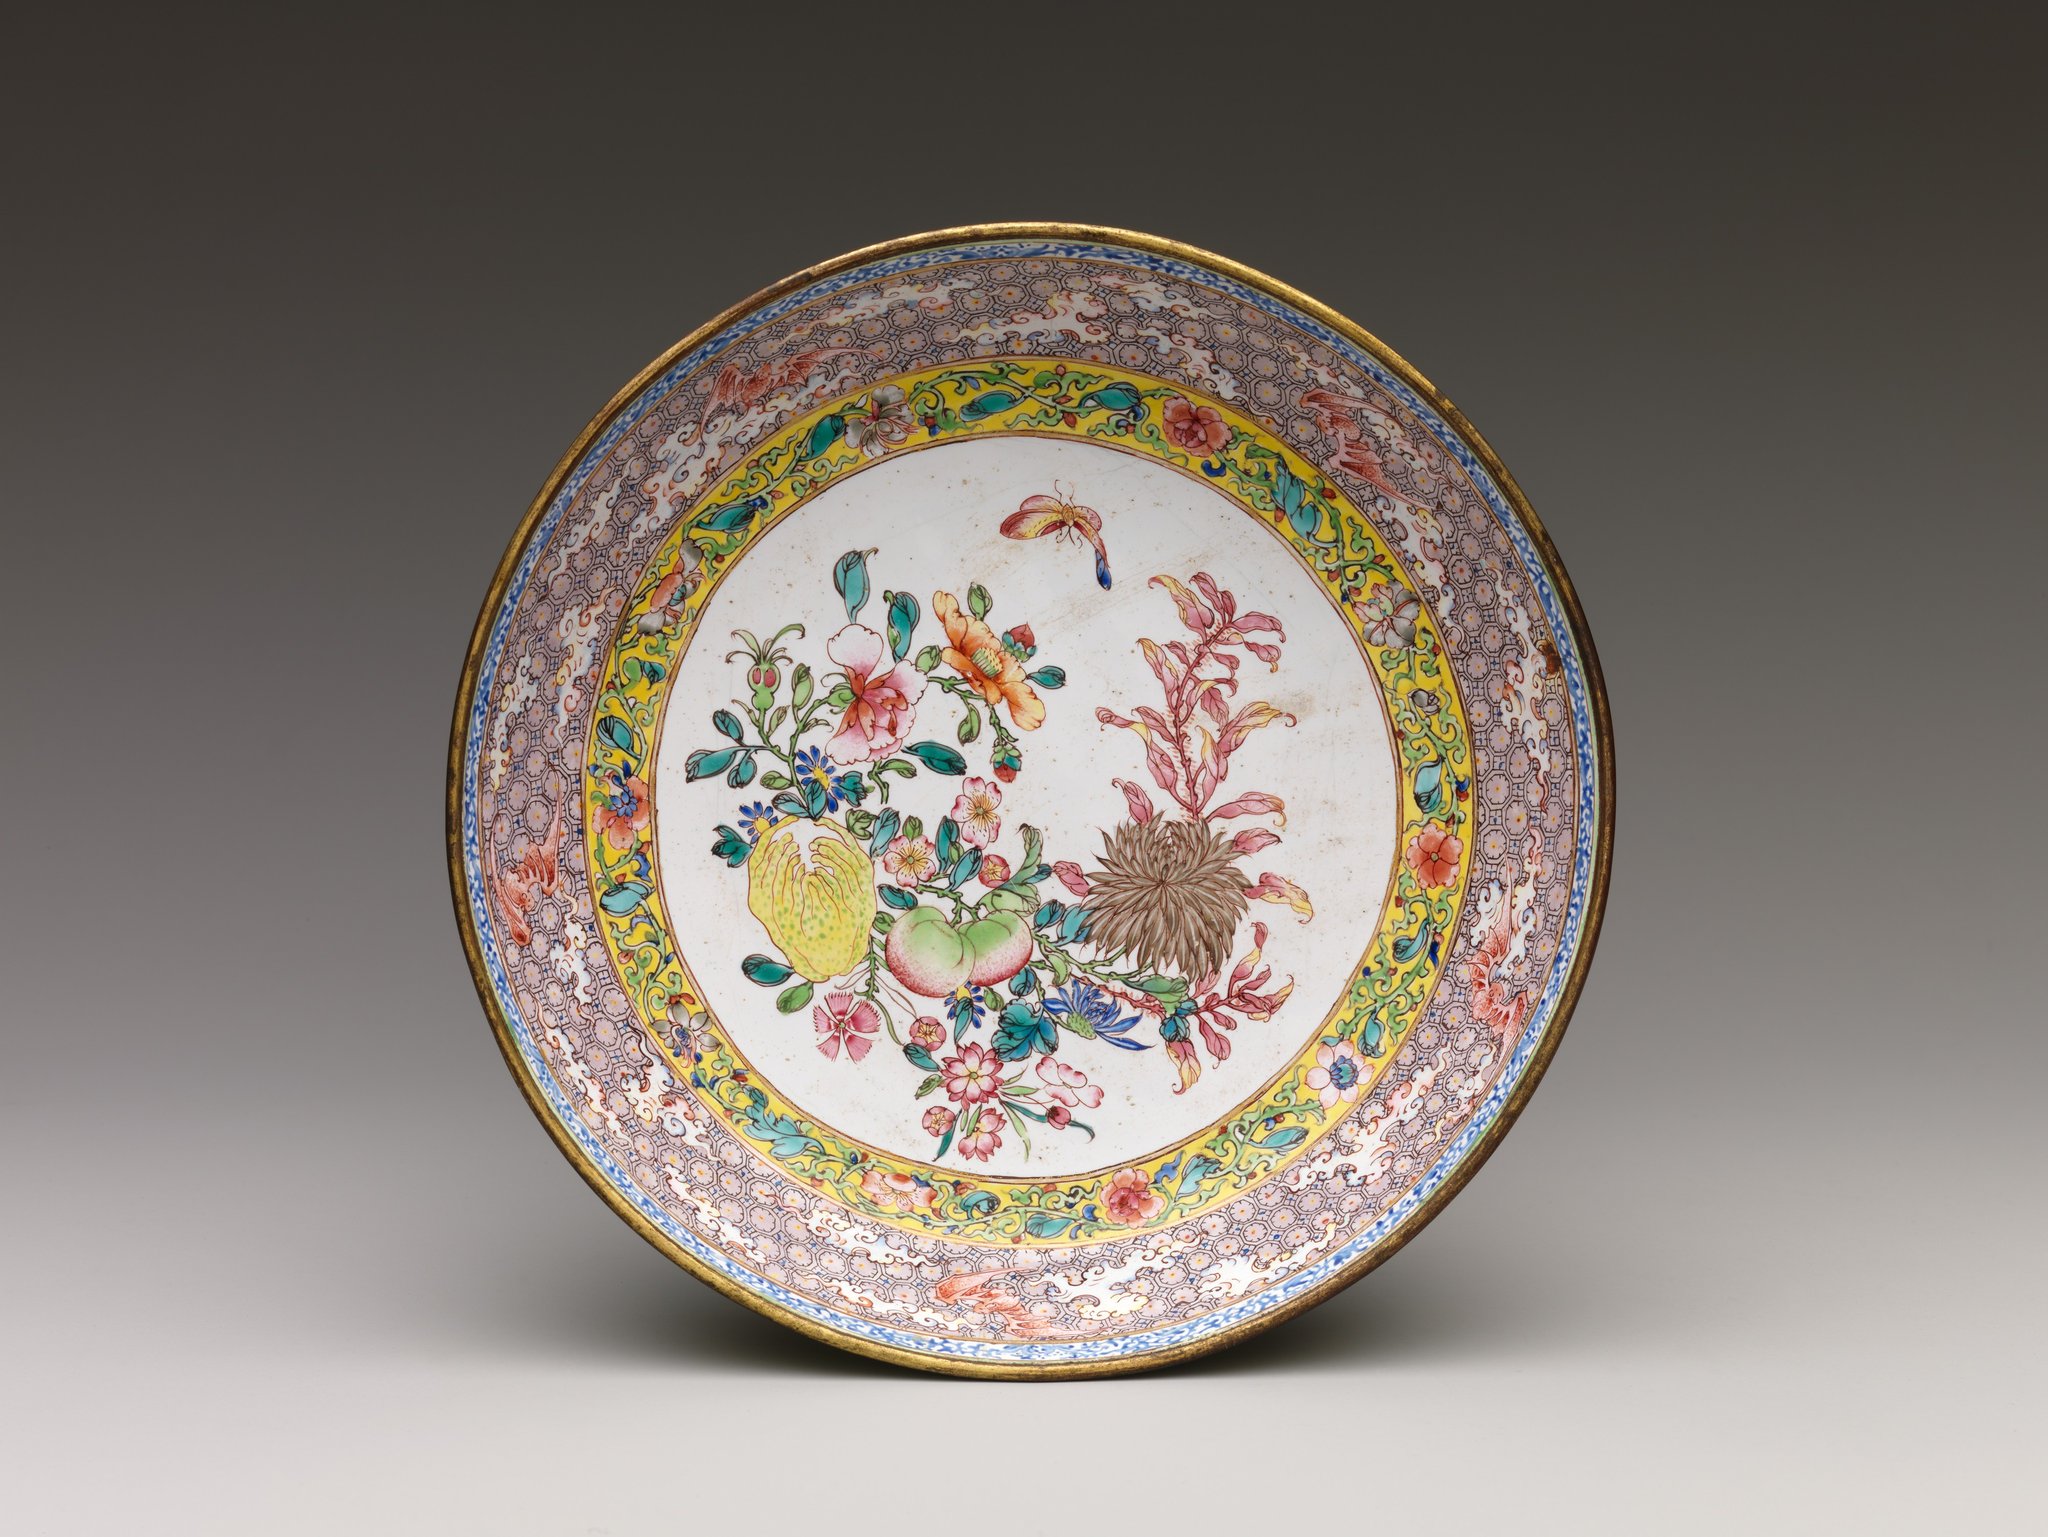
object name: dish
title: Dish with flowers, fruits, and butterfly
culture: chinese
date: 1734-1766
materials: copper alloy, enamel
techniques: painting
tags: butterflies,flowers